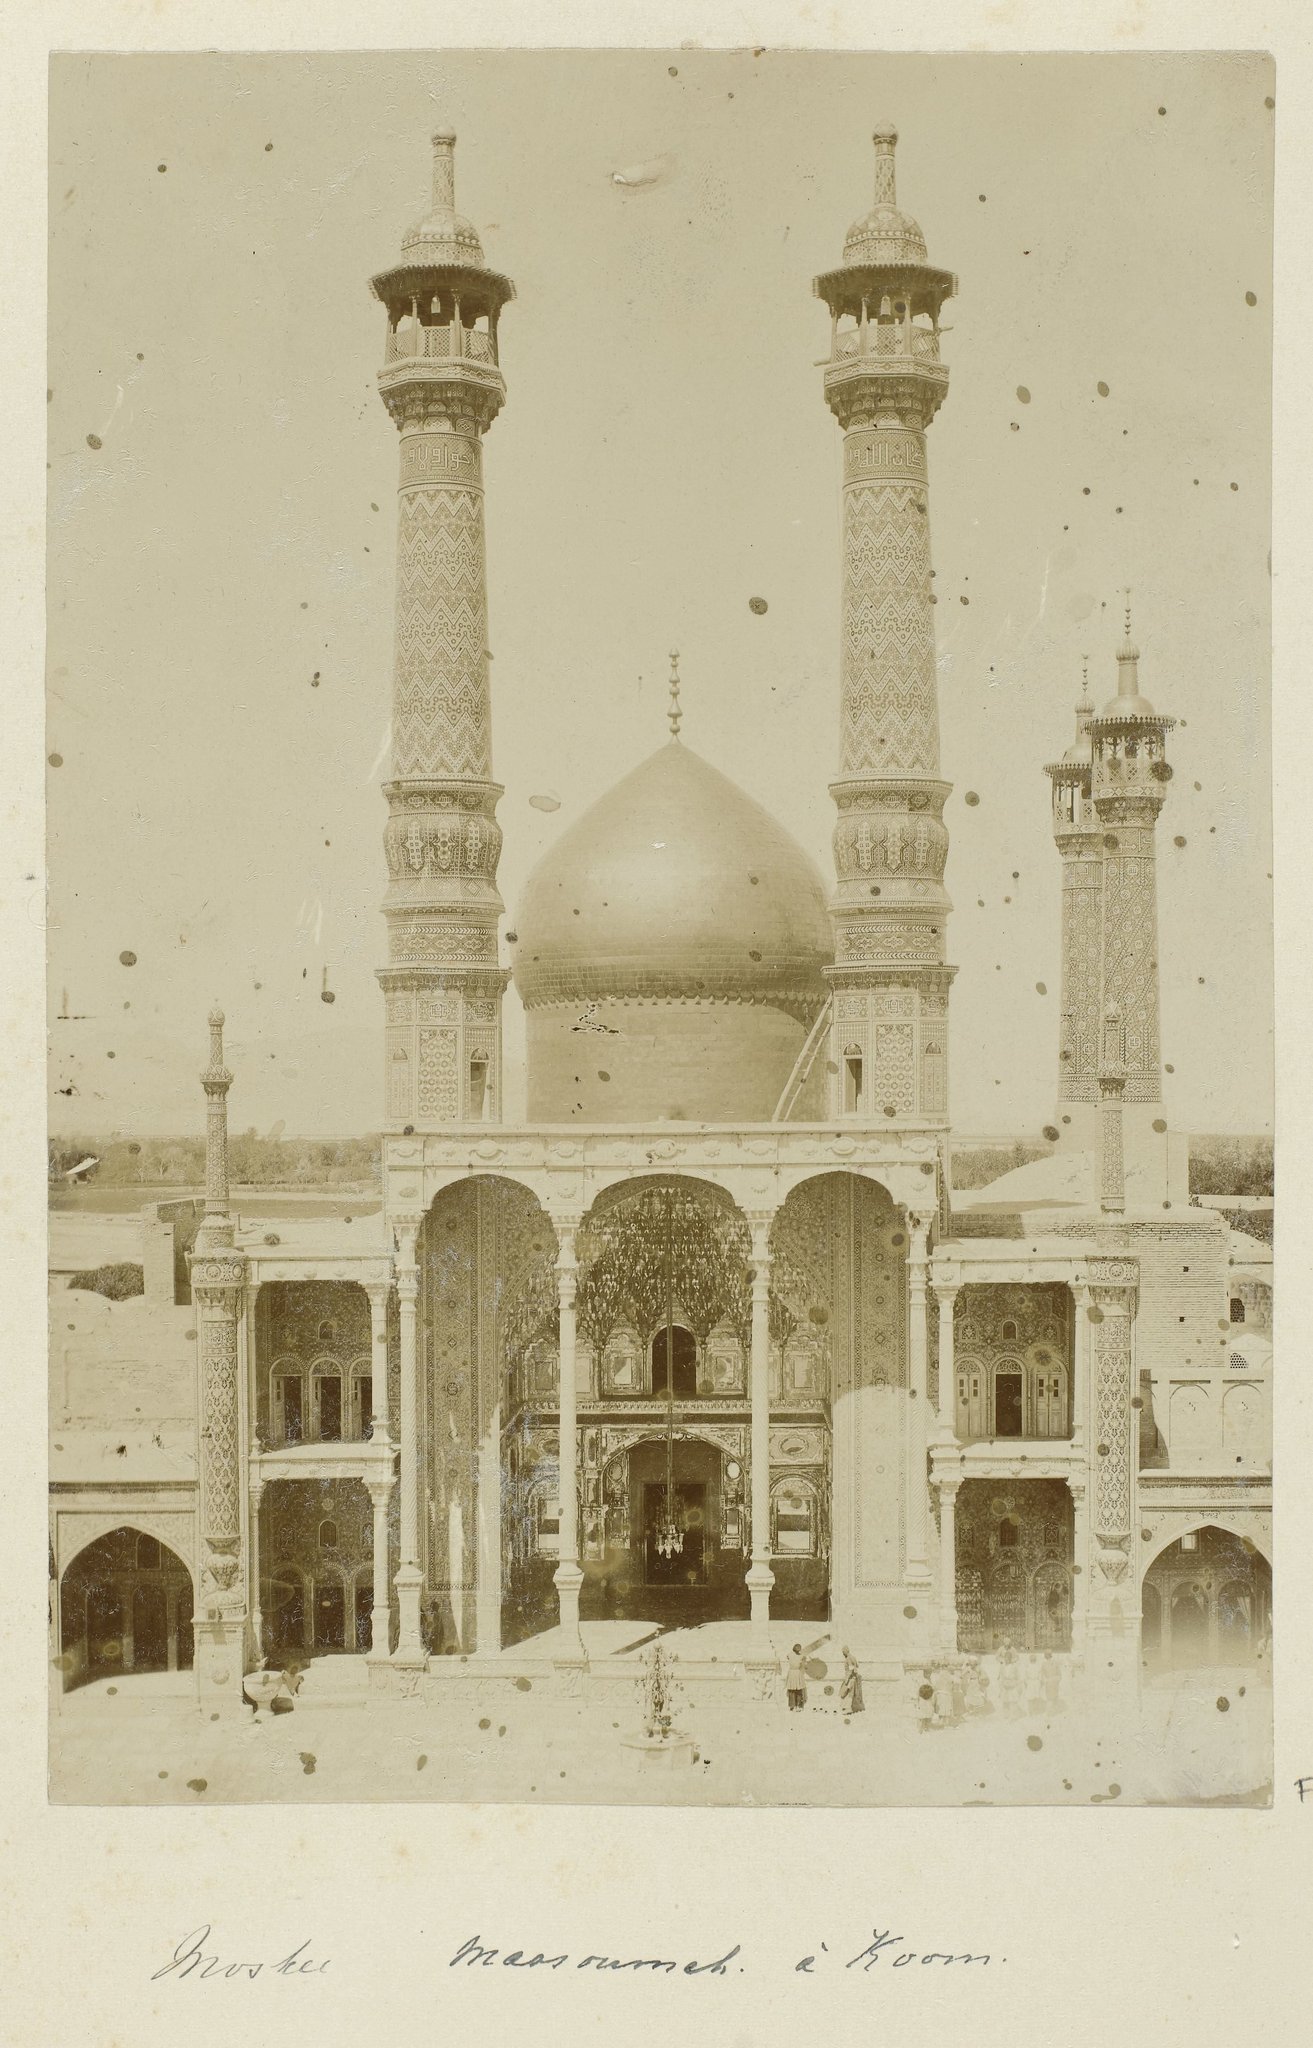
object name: photograph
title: Exterieur van de Fatima Masumehschrijn (Hazrat-e Masumeh) in Qom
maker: antoine sevruguin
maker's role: fotograaf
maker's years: 1840-1933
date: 1880-1895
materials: paper, photographic support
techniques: gelatin silver print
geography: qom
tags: temple, shrine ~ islam, mohammedanism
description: Onderdeel van Reisalbum van H. Dunlop met foto's van bezienswaardigheden in Perzië, Schotland, Duitsland, Rusland, China en Canada.